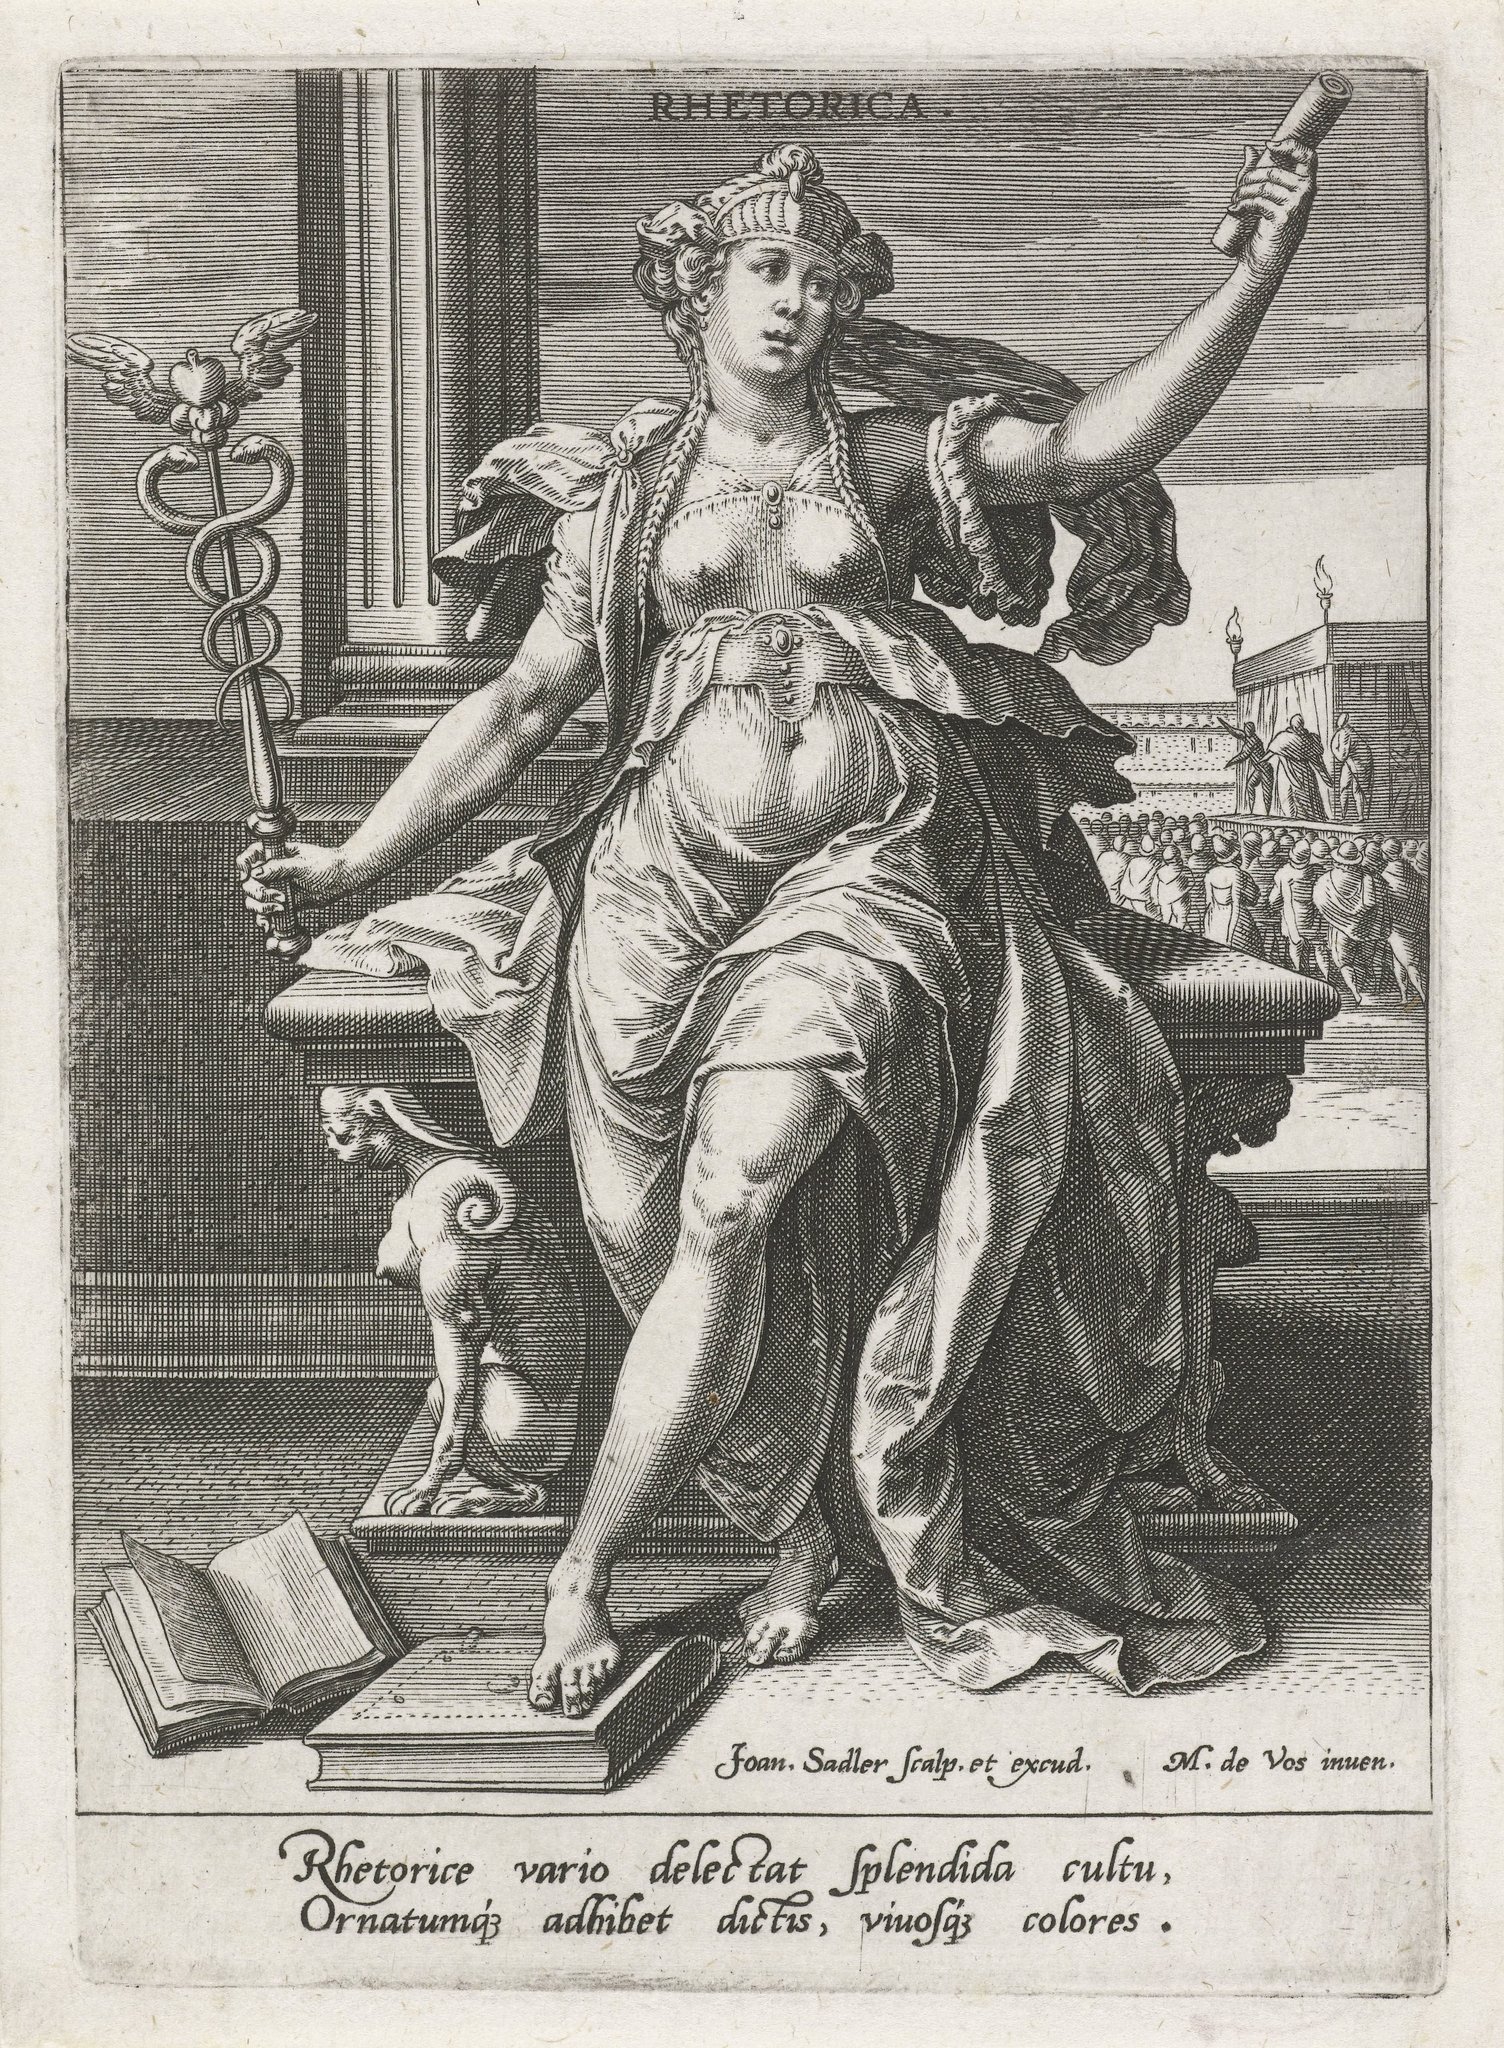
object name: print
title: Rhetorica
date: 1560-1600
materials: paper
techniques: engraving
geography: antwerp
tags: group of actors, troupe; actors on the stage, 'rhetorica', 'eloquentia' (~ trivium); 'rettorica' (ripa), caduceus (staff with two snakes, attribute of mercury)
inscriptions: collector's mark: Lugt 240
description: De personificatie van retorica met een caduceus in haar hand. In de andere hand een perkamentrol. Op de voorgrond liggen boeken op het gebied van retorica. Op de achtergrond een podium met een toneelvoorstelling. De prent heeft een Latijns onderschrift over de retorica en maakt deel uit van een zevendelige serie over de zeven vrije kunsten.